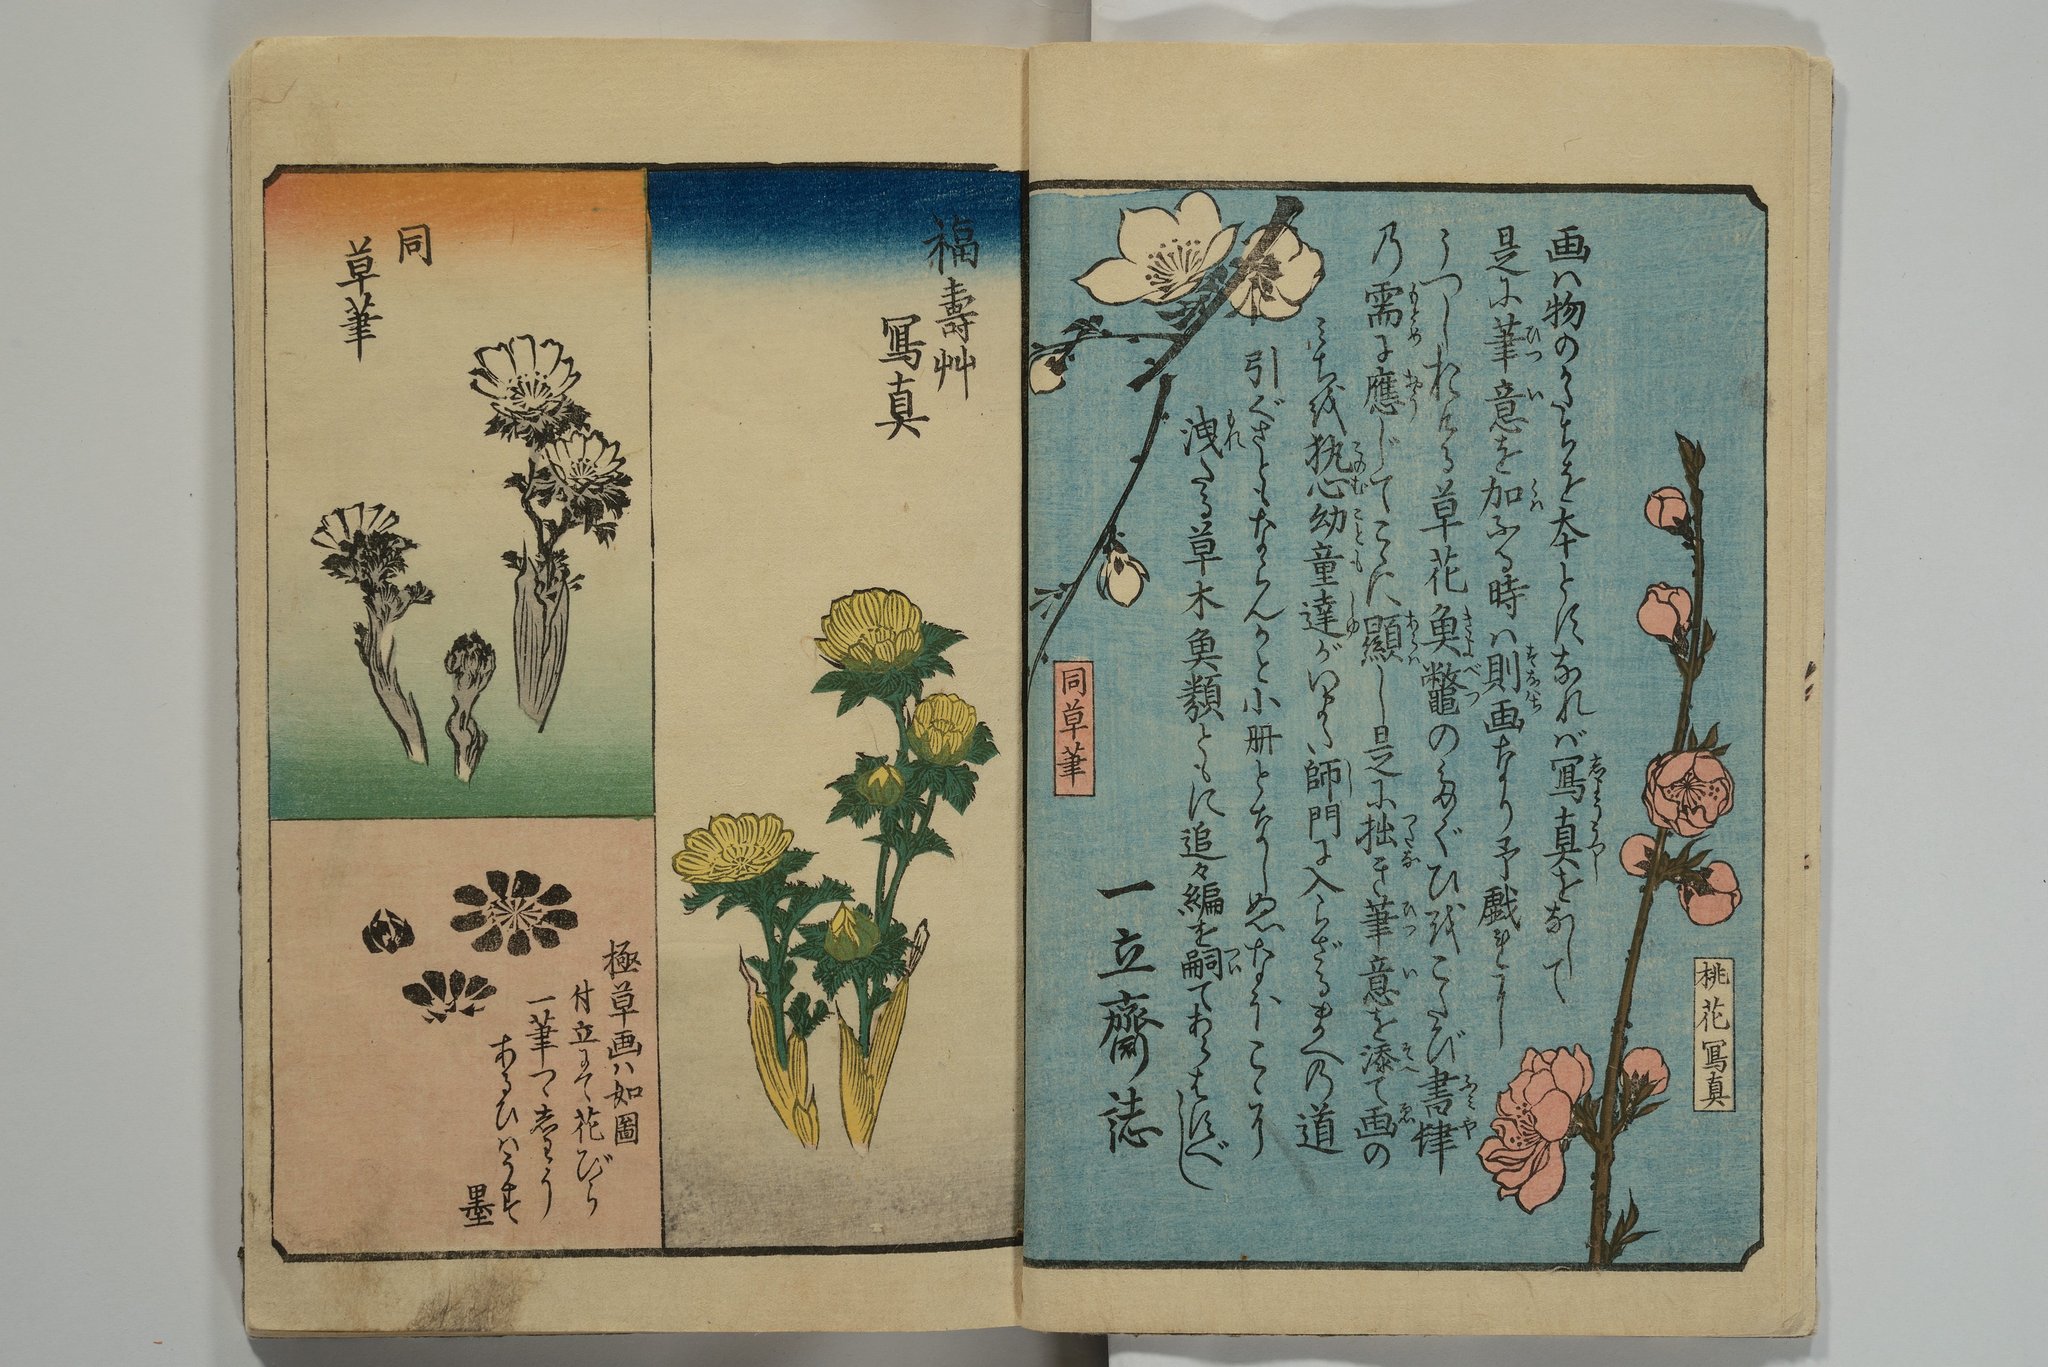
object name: illustrated book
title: Picture Book for the Practice of Drawing (Ehon tebikigusa) 絵本手引草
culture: japanese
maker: utagawa hiroshige 歌川広重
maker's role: artist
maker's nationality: japanese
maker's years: 1797-1858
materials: ink, paper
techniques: woodblock print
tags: flowers